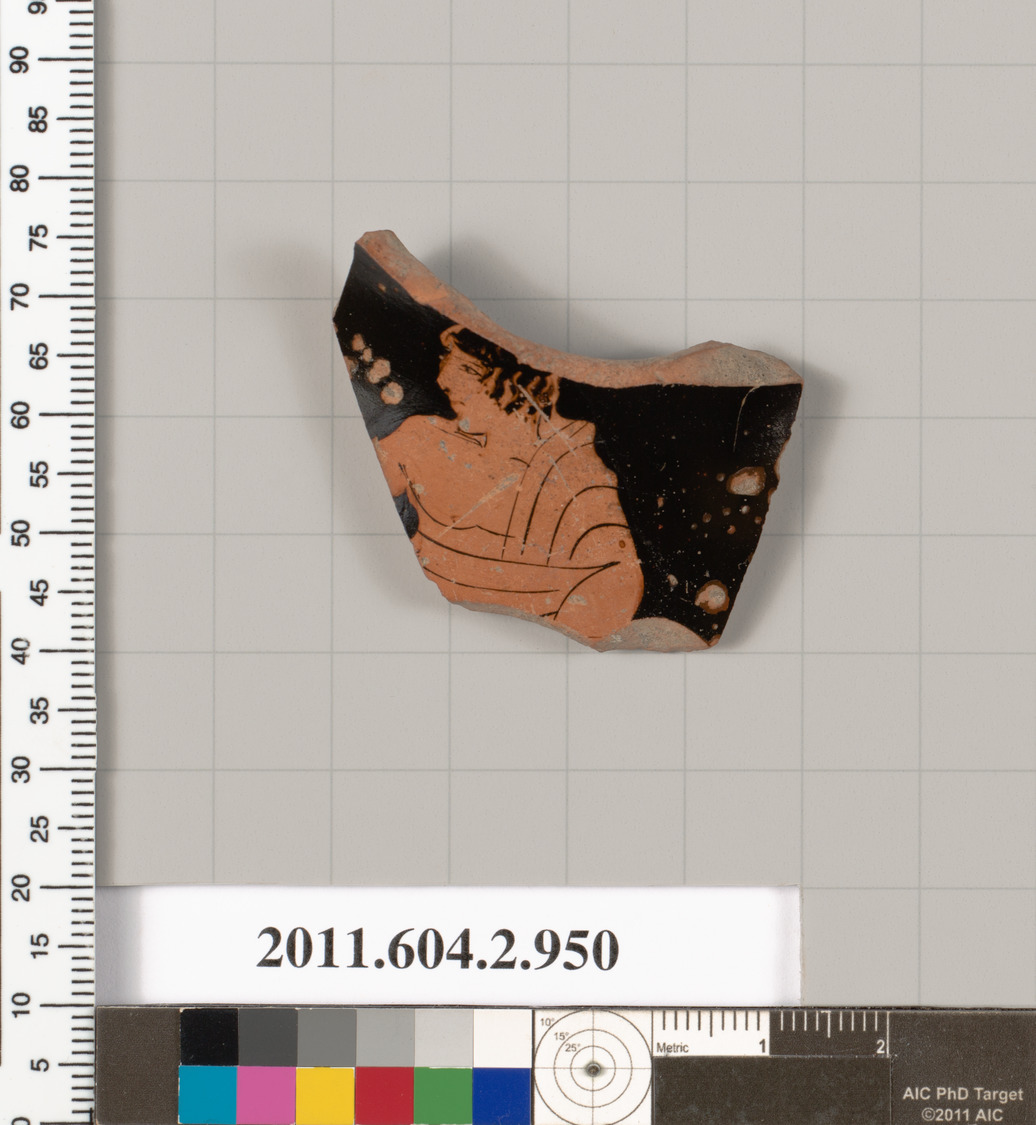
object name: oinochoe fragment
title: Terracotta fragment of an oinochoe (jug)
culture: greek, attic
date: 450-440 BCE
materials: terracotta